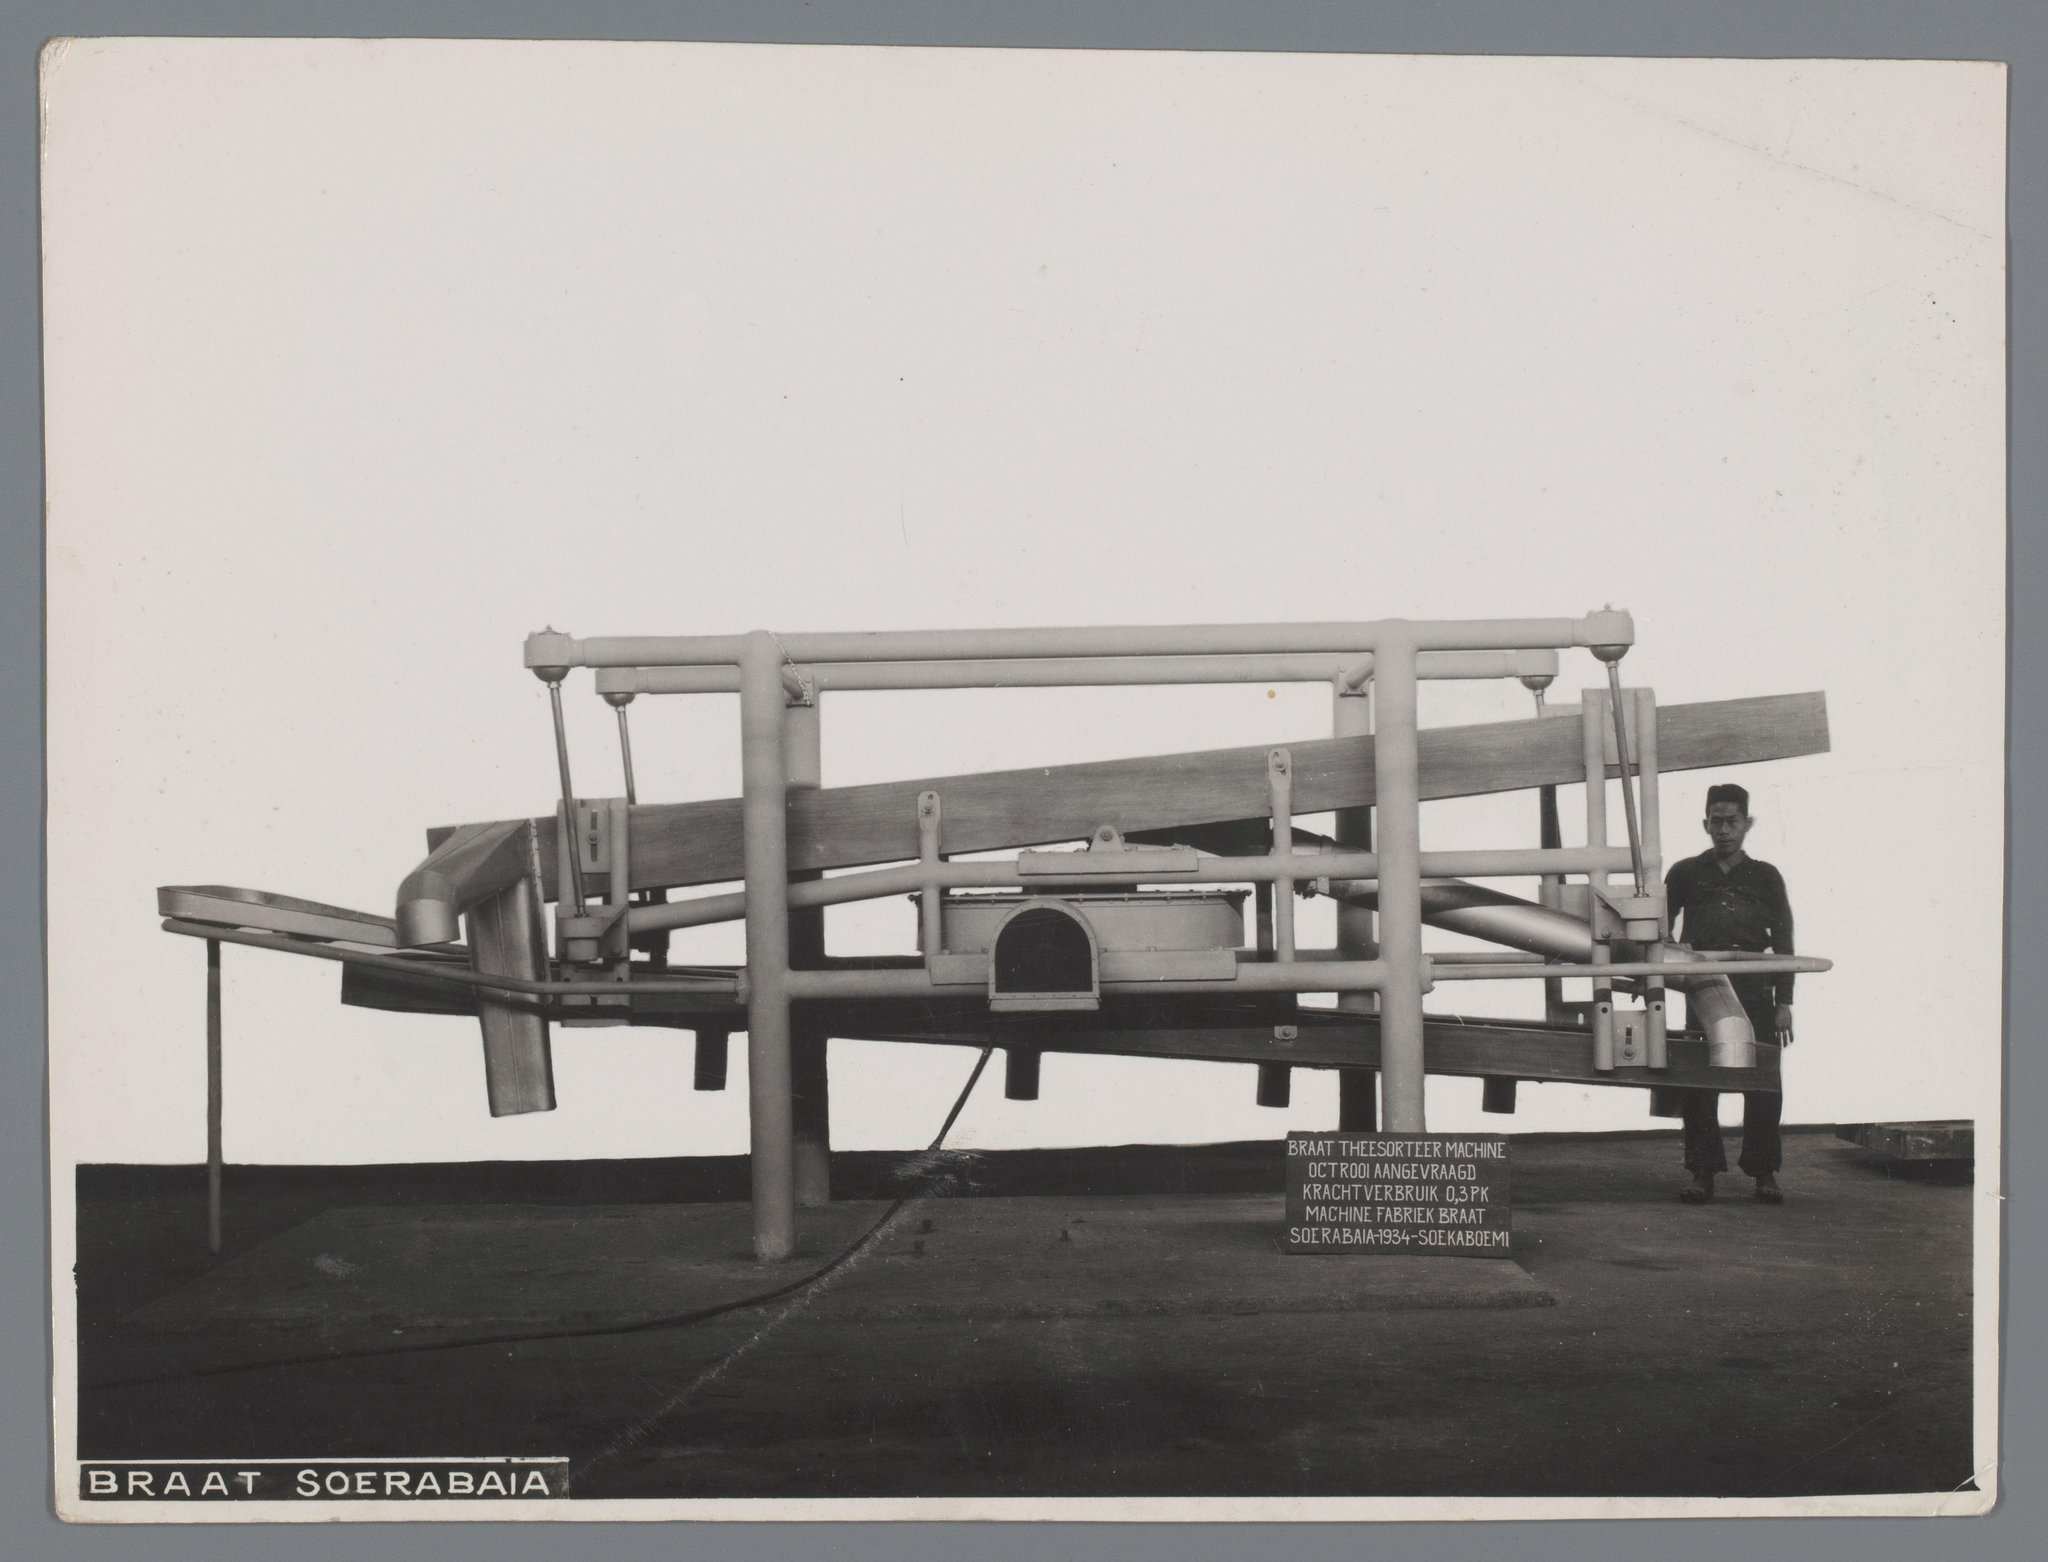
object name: photograph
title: Theesorteermachine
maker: Anonymous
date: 1903-1934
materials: photographic support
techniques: gelatin silver print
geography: surabaya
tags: colonial system, machines; parts of machines; tools and appliances, workshop-interior (+ men (labourers)), (non-fruit) products of plants or trees (with name), tea (leaves), java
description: Theesorteermachine, vervaardigd en octrooi aangevraagd in 1934. Onderdeel van de multomap met foto's van machines van de N.V. Machinefabriek Braat te Soerabaja en Soekaboemi bestemd voor de Nederlandse theeindustrie op Java en Sumatra, uit de periode 1931-1937.